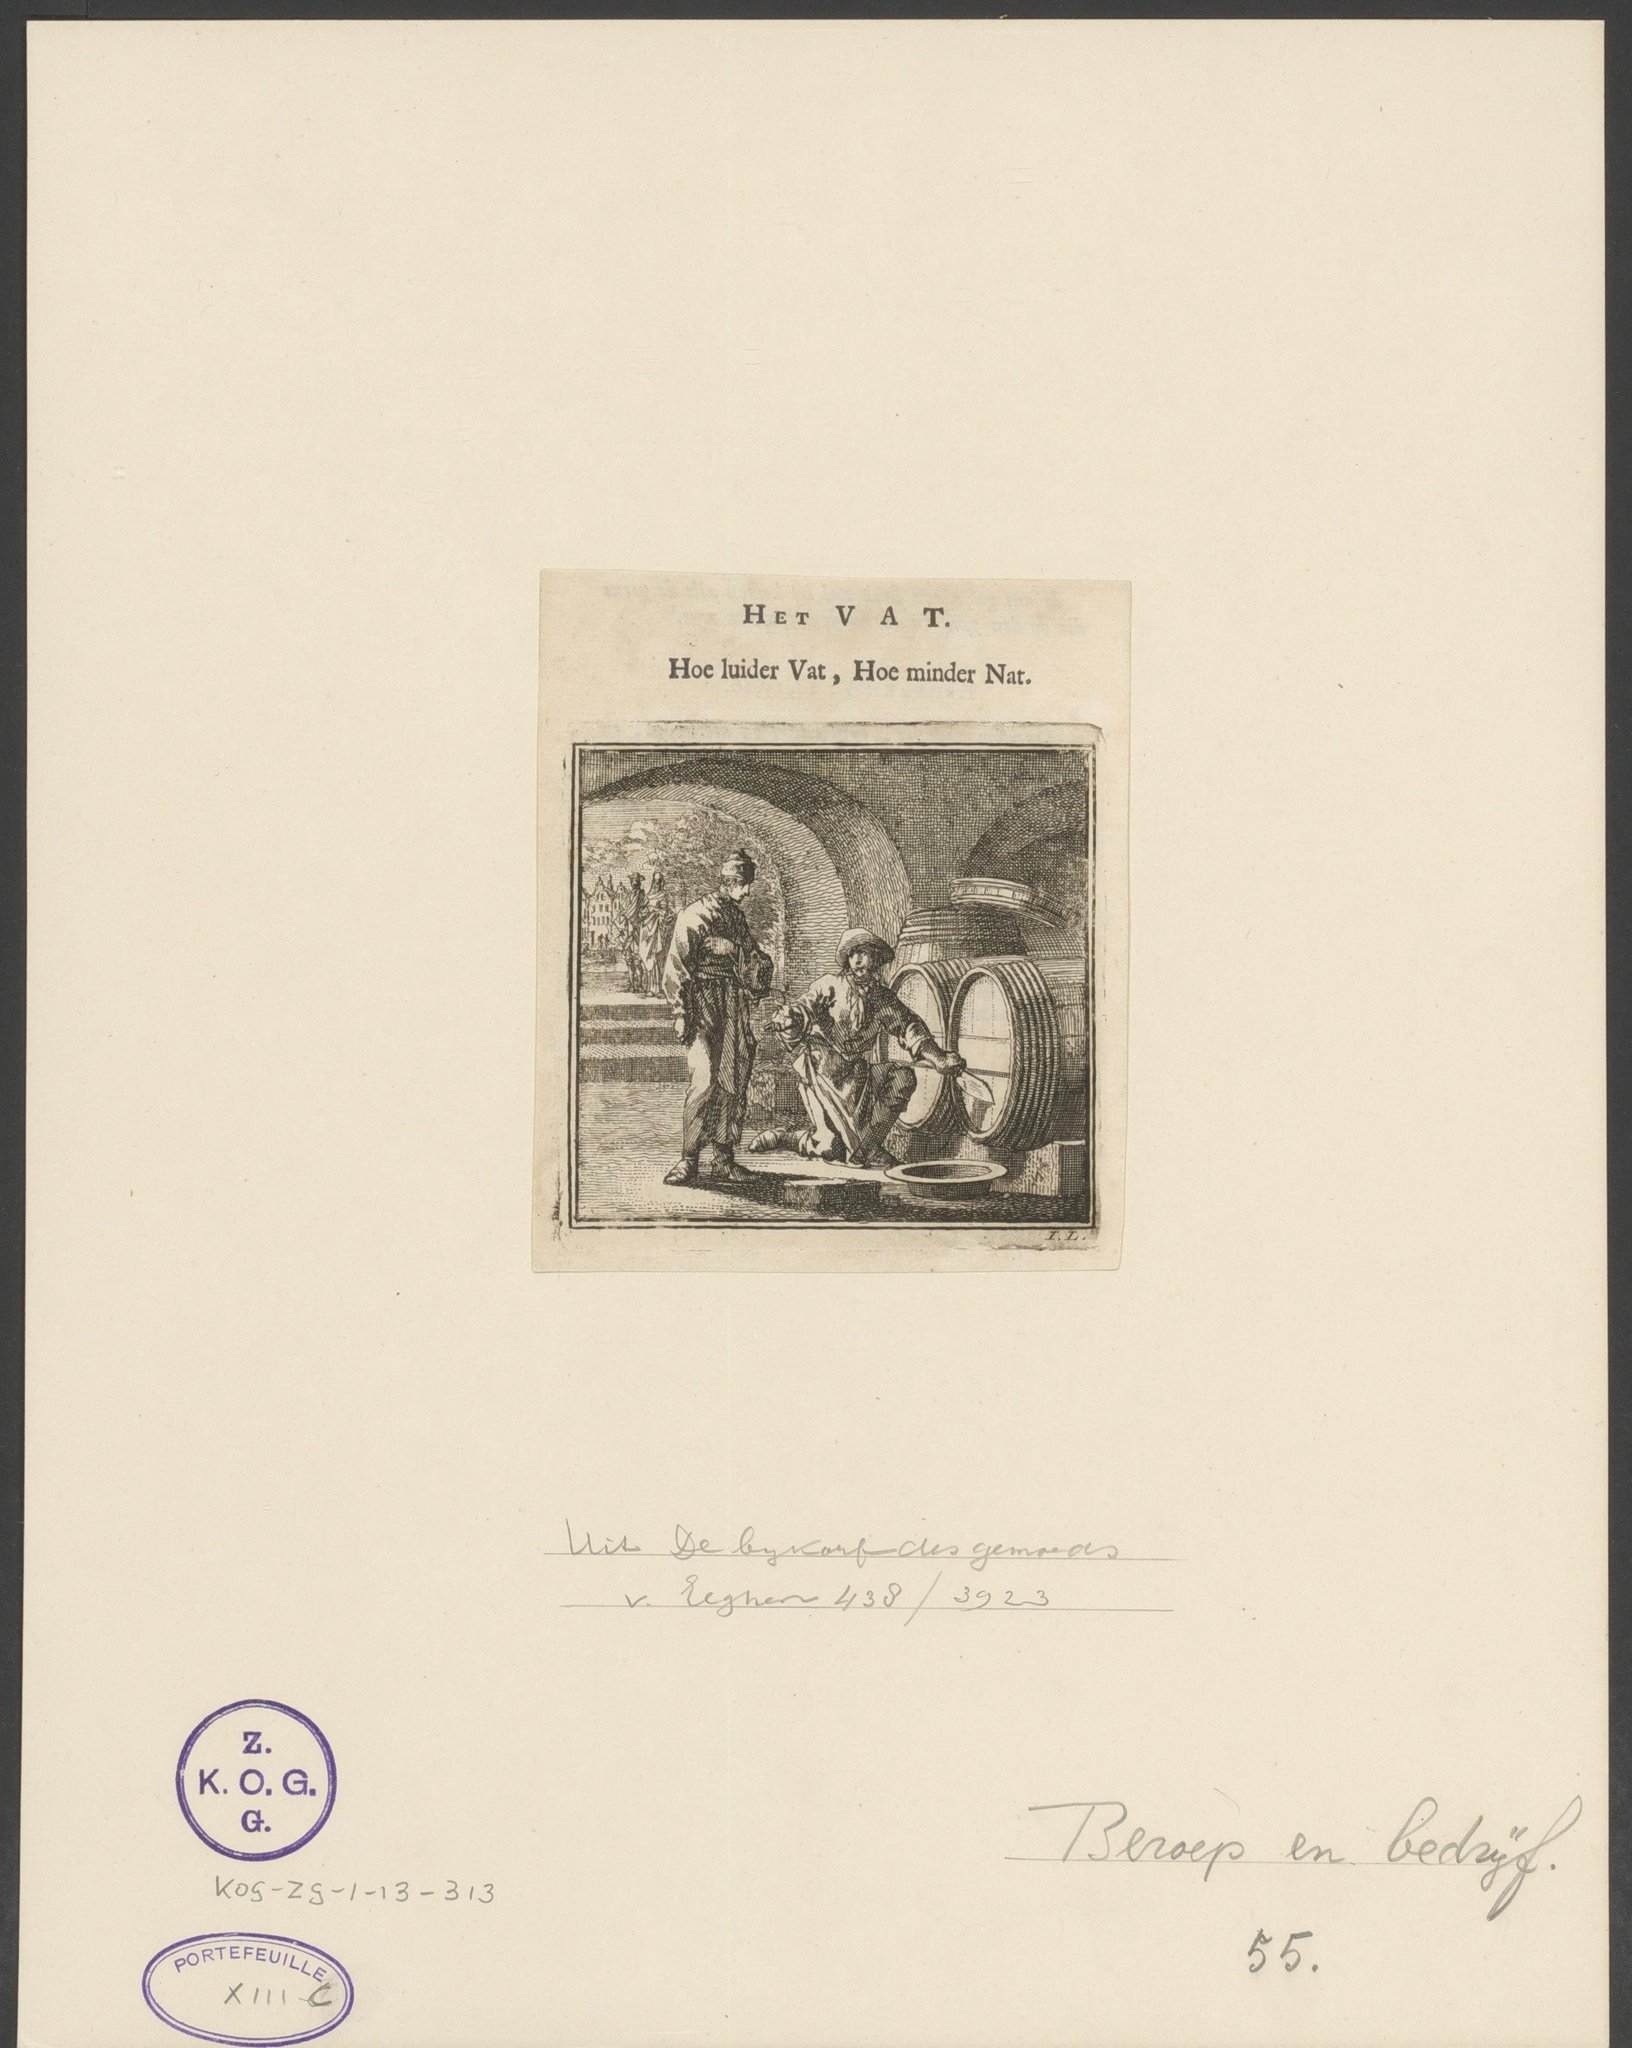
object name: book illustration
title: De Vat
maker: jan luyken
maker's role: draughtsman, print maker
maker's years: 1649-1712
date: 1711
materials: paper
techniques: etching, letterpress printing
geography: amsterdam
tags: wine-cellar, wooden container: barrel, cask, bucket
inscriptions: stamp, collector's mark: Lugt 1641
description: Onderwerpsrubrieken binnen de Atlas Zeden en Gewoonten: Handel, Nijverheid en verkeer, Beroep en bedrijf, Mannelijk, Bewerkers van het hout.